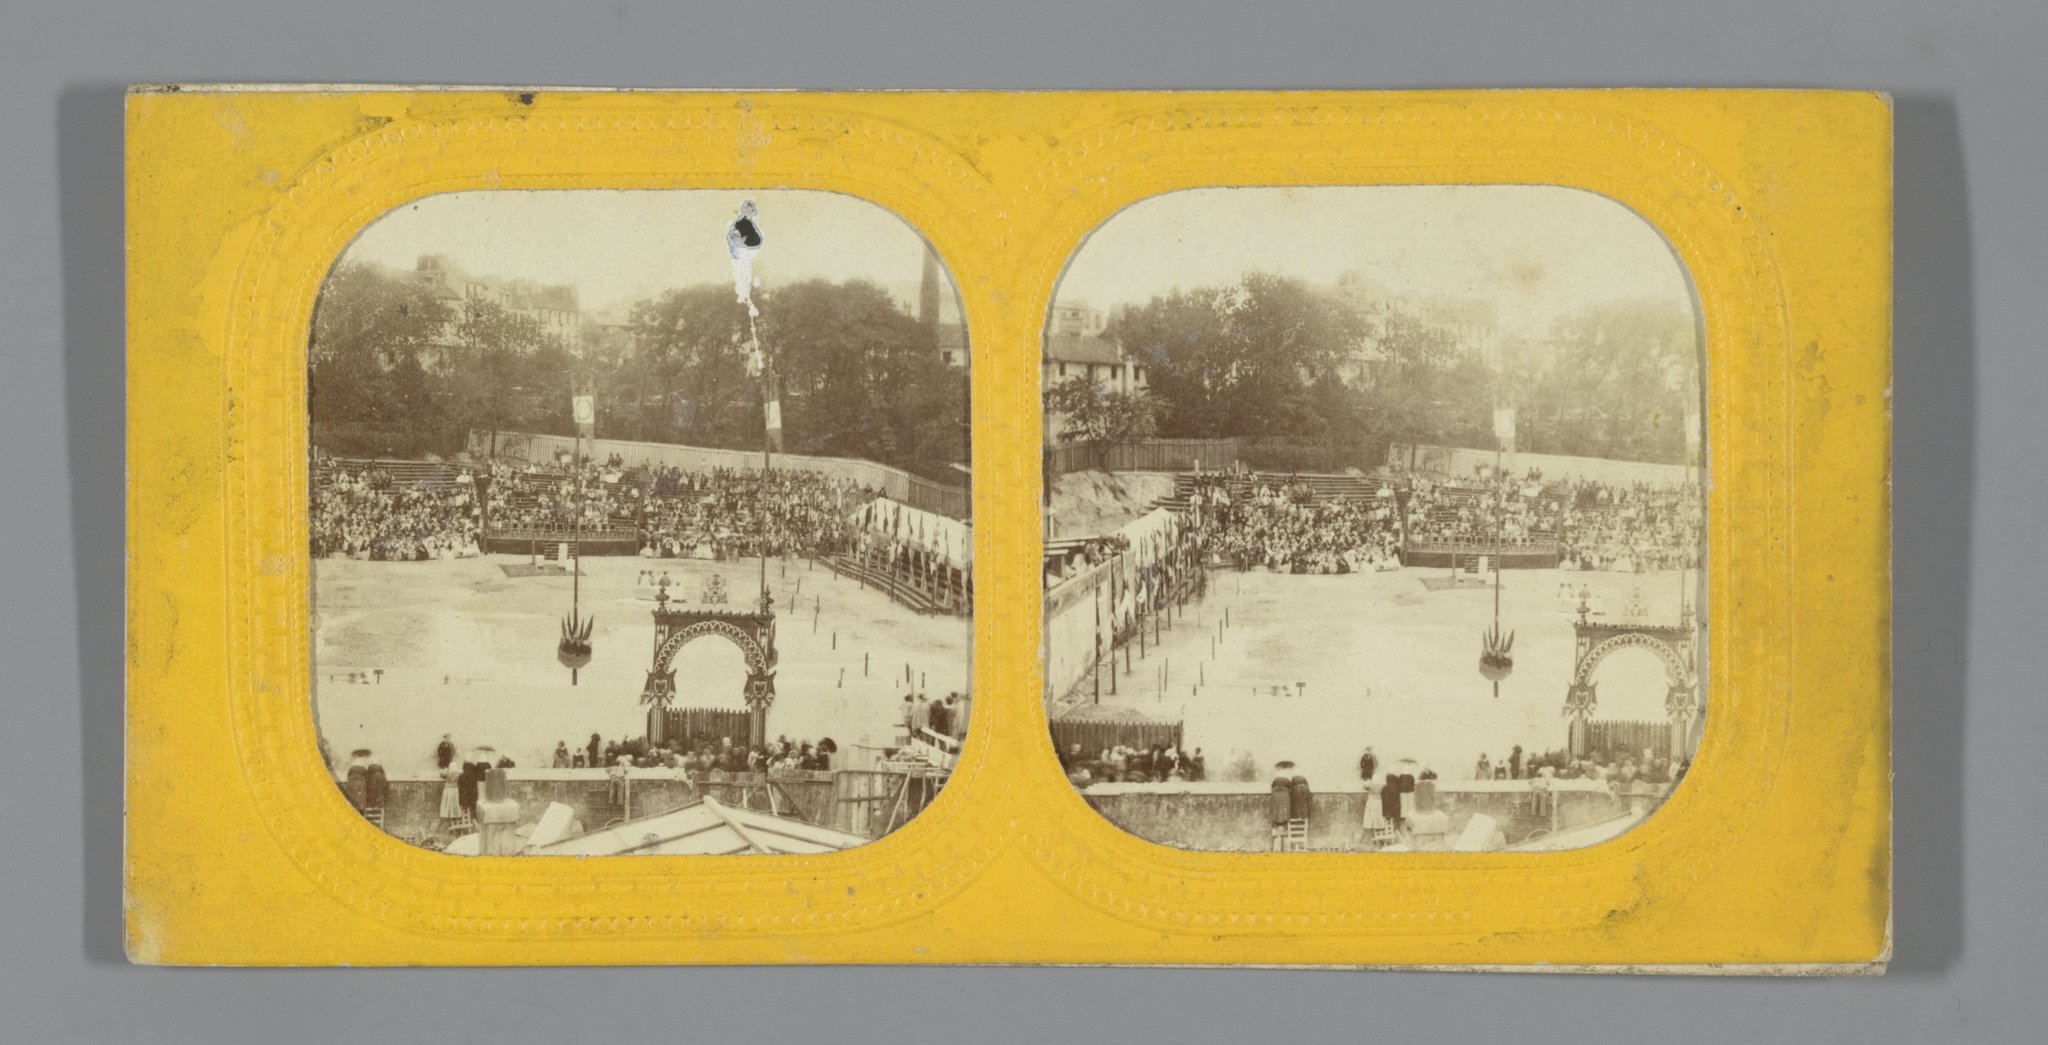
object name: tissue stereograph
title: Publiek in arena tijdens feestelijke gebeurtenis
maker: Anonymous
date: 1855-1875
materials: cardboard, paper, photographic support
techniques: albumen print, hand coloring, perforating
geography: asia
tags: amphitheatre